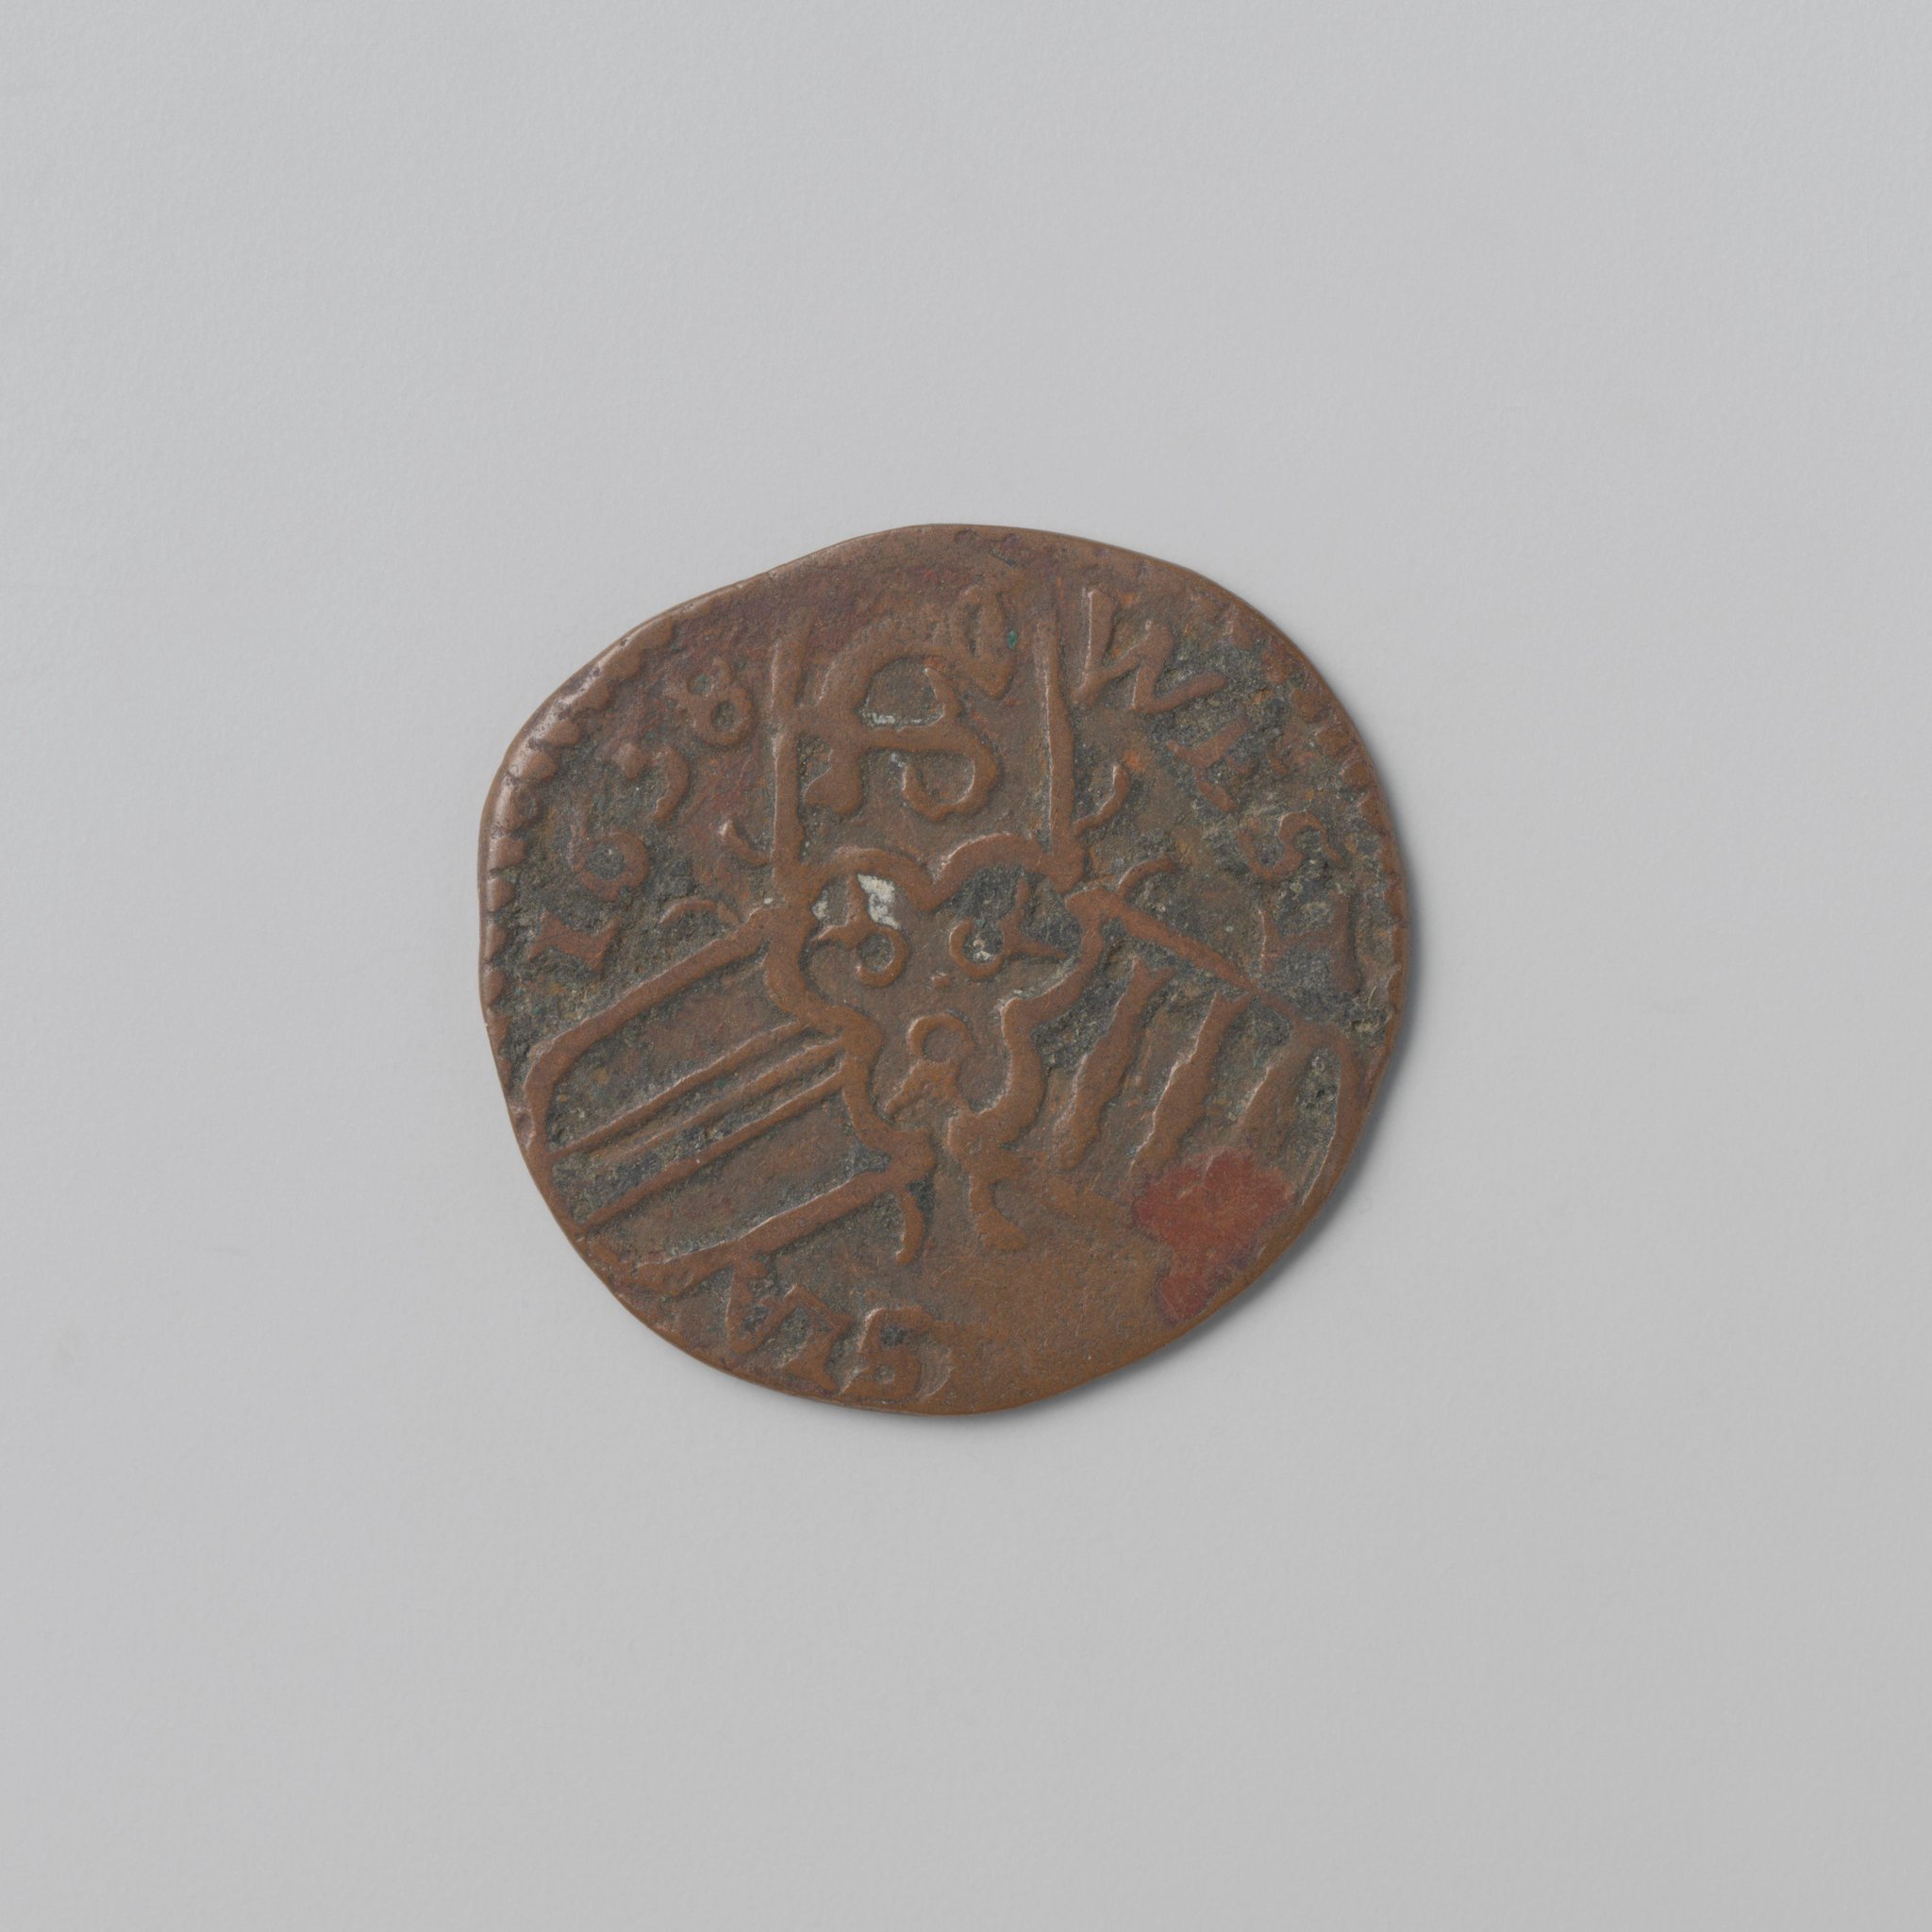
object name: coin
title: Westfriese duit, 1658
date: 1658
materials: copper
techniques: striking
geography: west frisia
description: Koperen munt. Voorzijde: gekroond en versierd wapenschild van West-Friesland. Keerzijde: drie versierde, aan bovenkant gebogen wapenschilden van Enkhuizen, Hoorn en Medemblik.